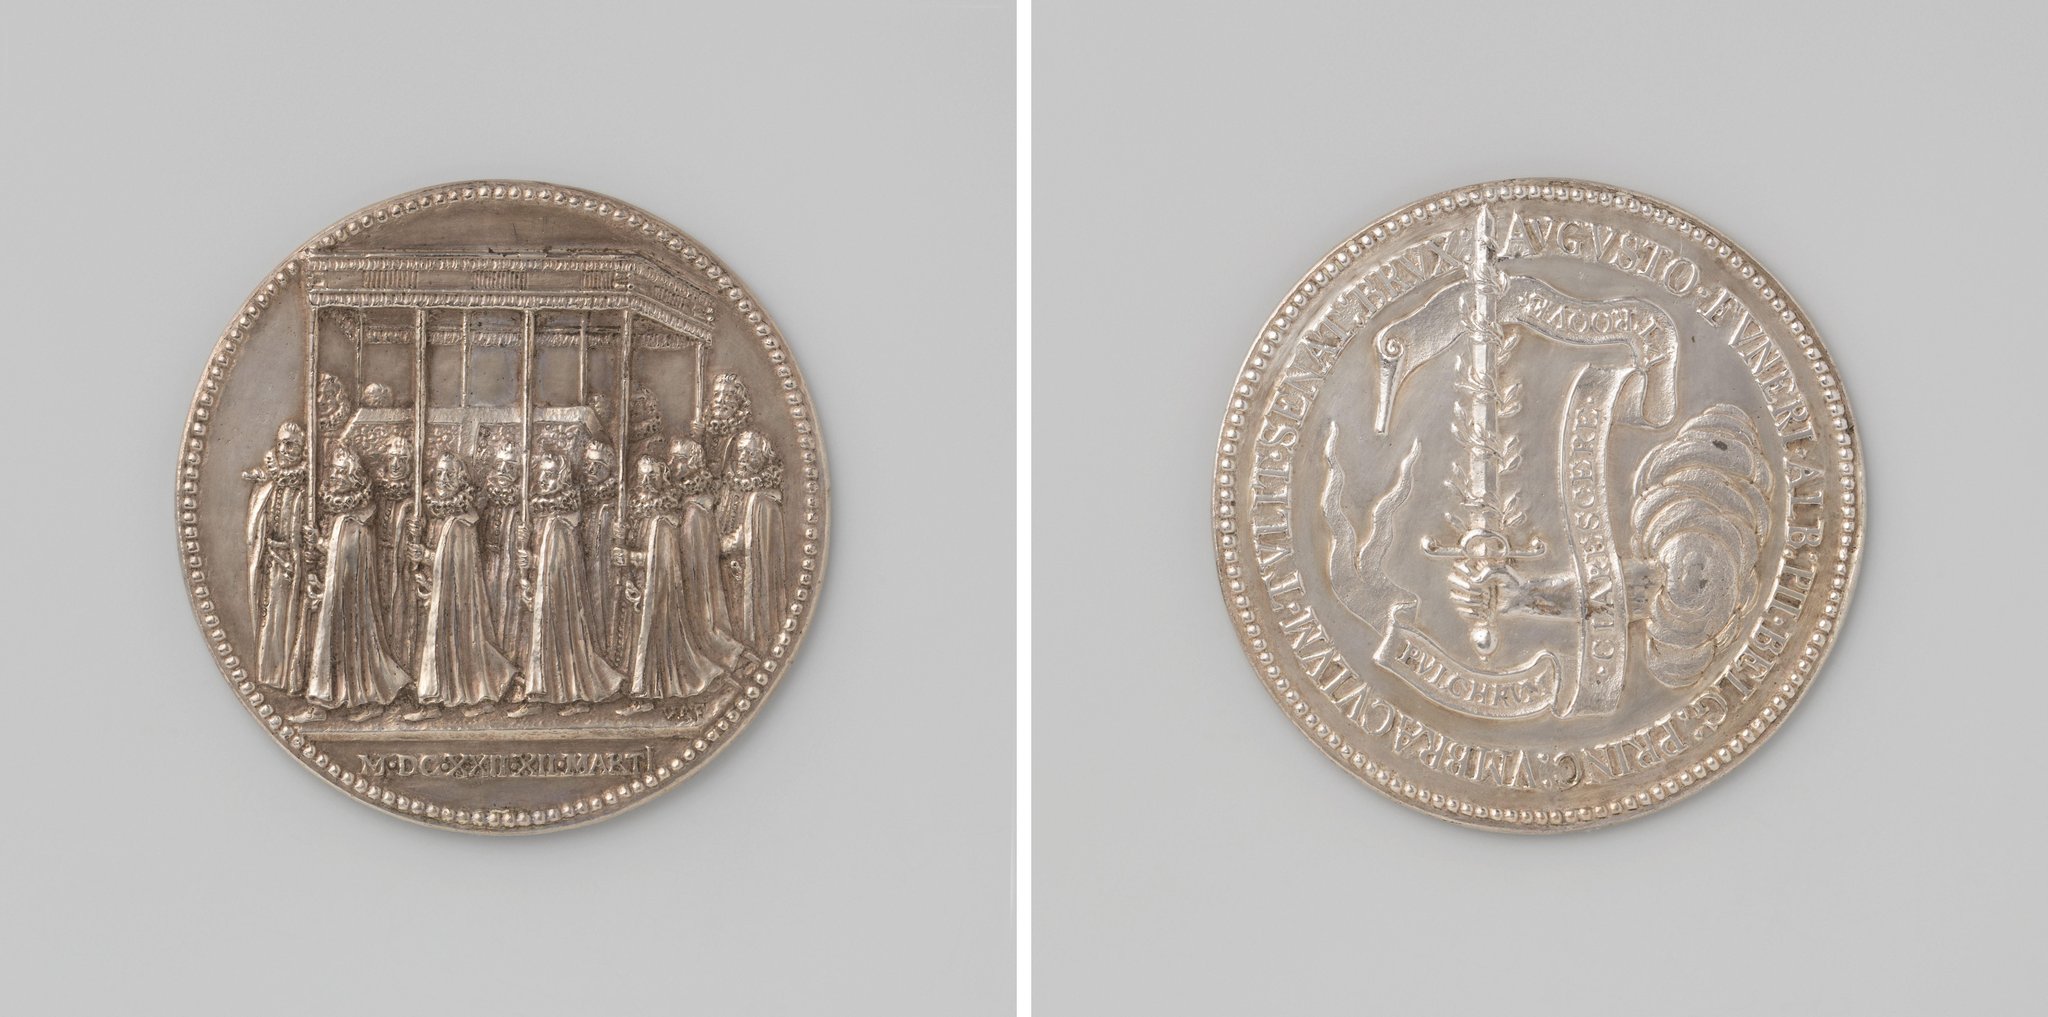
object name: history medal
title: Begrafenis van Albertus van Oostenrijk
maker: adriaan waterloos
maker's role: medailleur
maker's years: 1600-1684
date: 1621-1622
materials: silver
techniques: casting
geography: brussels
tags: brussels, albrecht aartshertog van oostenrijk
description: Zilveren penning. Voorzijde: lijkstoet boven opschrift. Keerzijde: hand uit wolken houdt zwaard omwonden met olijftak en omgeven door wimpel met opschrift, binnen omschrift